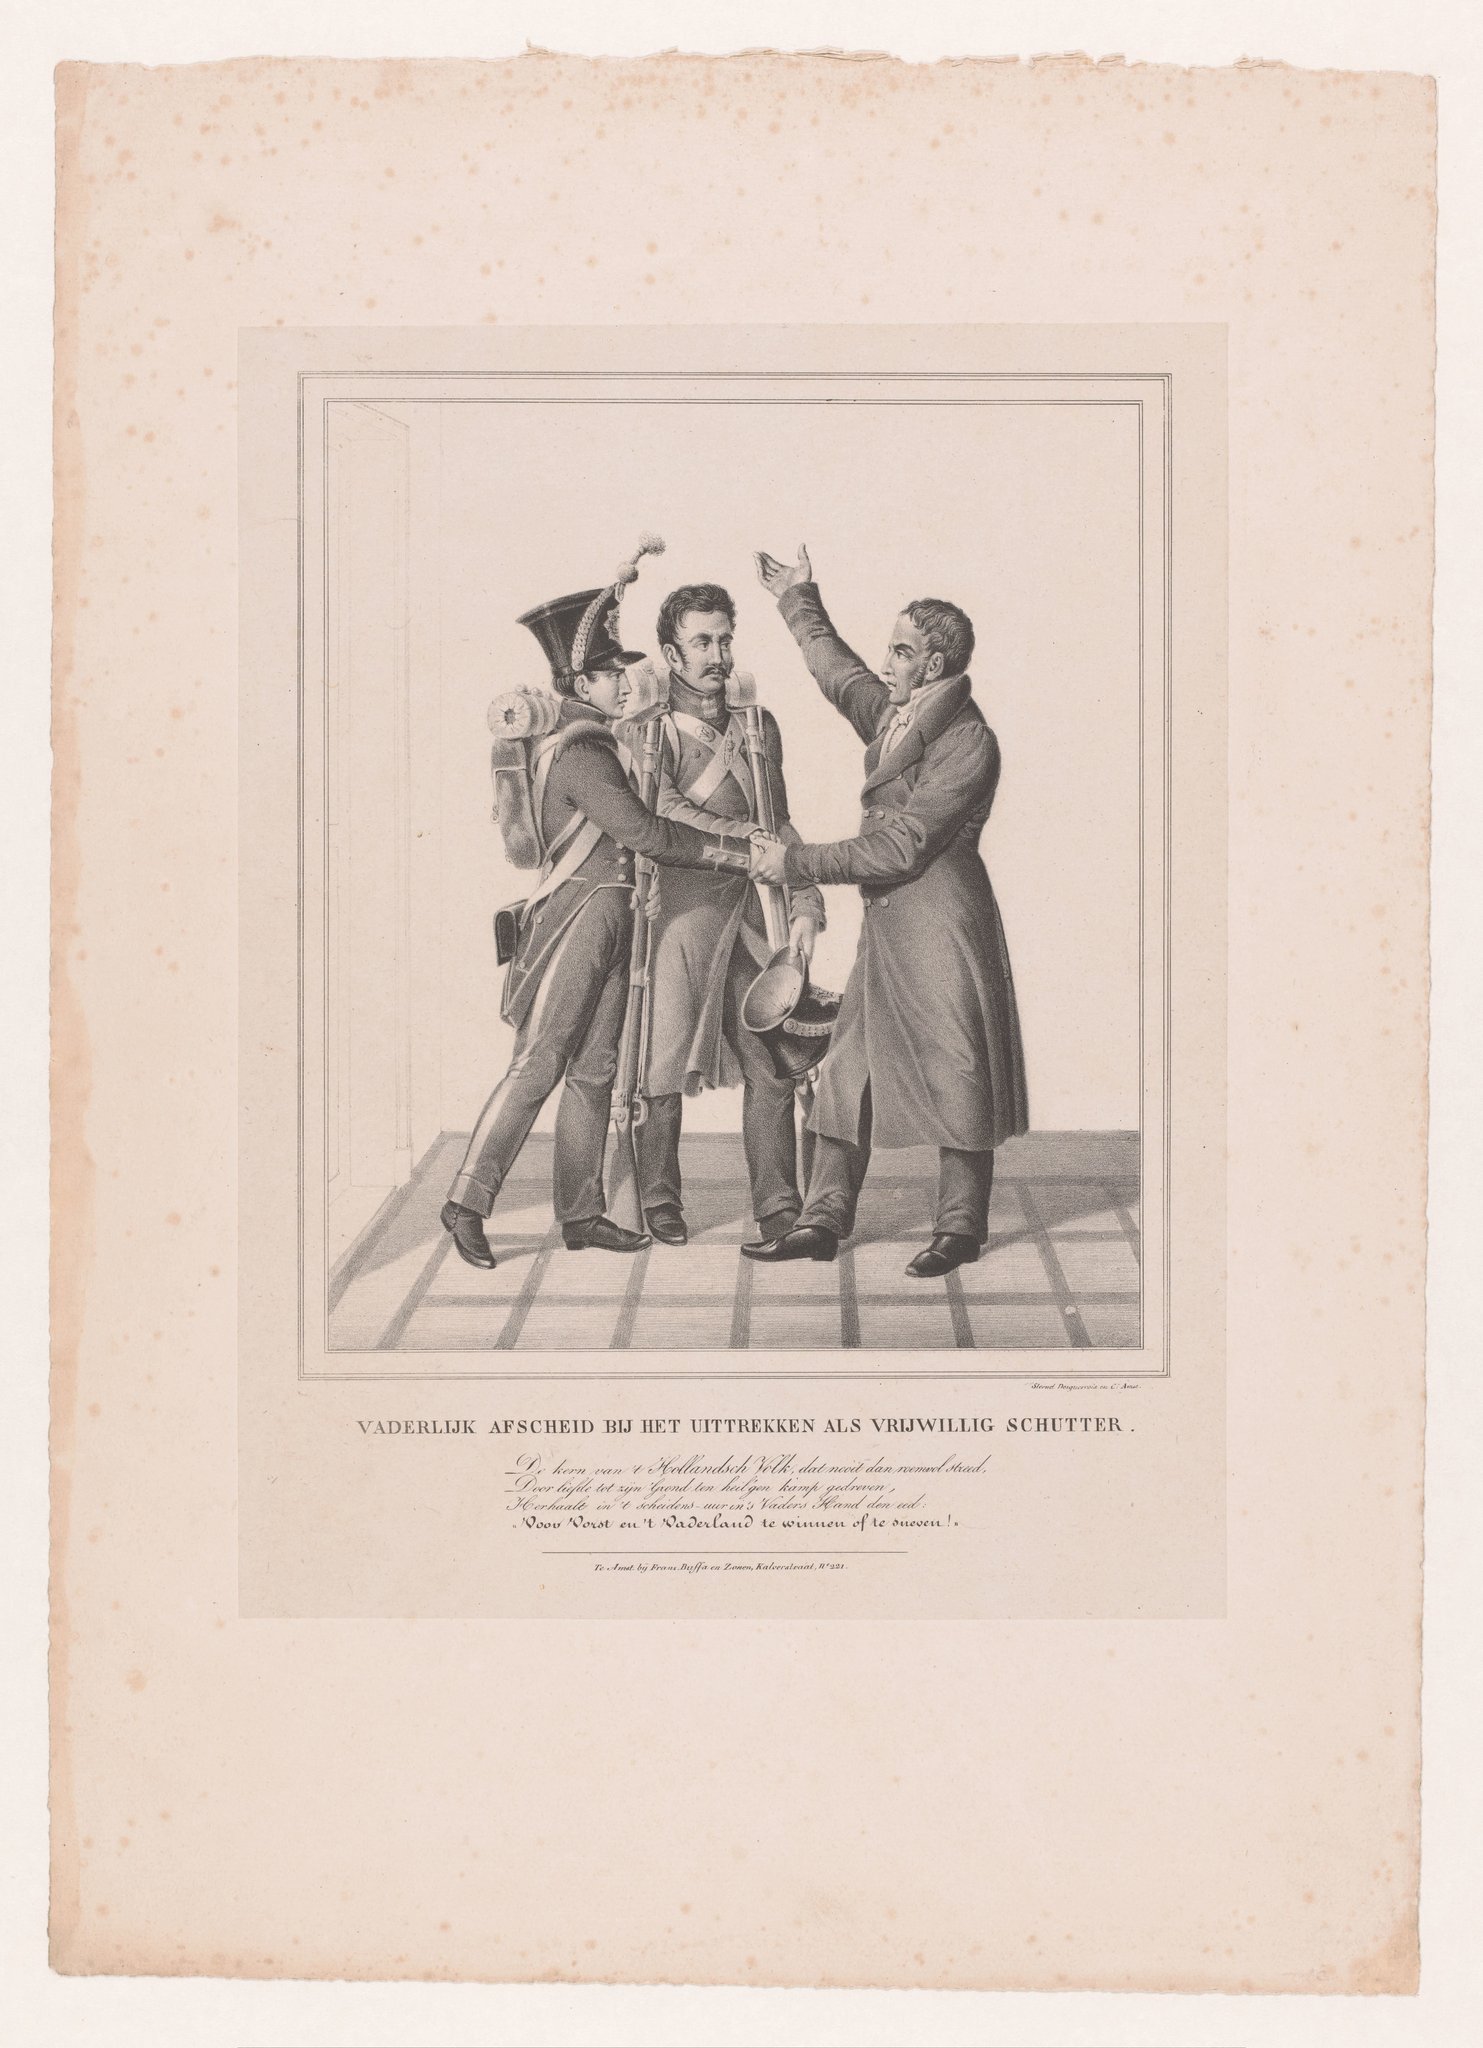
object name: print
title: Vaderlijk afscheid bij het uittrekken als vrijwillige schutter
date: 1830-1831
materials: paper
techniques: lithograph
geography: amsterdam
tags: leave-taking (of soldiers), waving farewell ~ departure on a journey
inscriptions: collector's mark: Lugt 2228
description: Een Nederlandse vrijwillige schutter schudt de hand en neemt afscheid van zijn vader, ca. oktober 1830. In het onderschrift een vierregelig vers.